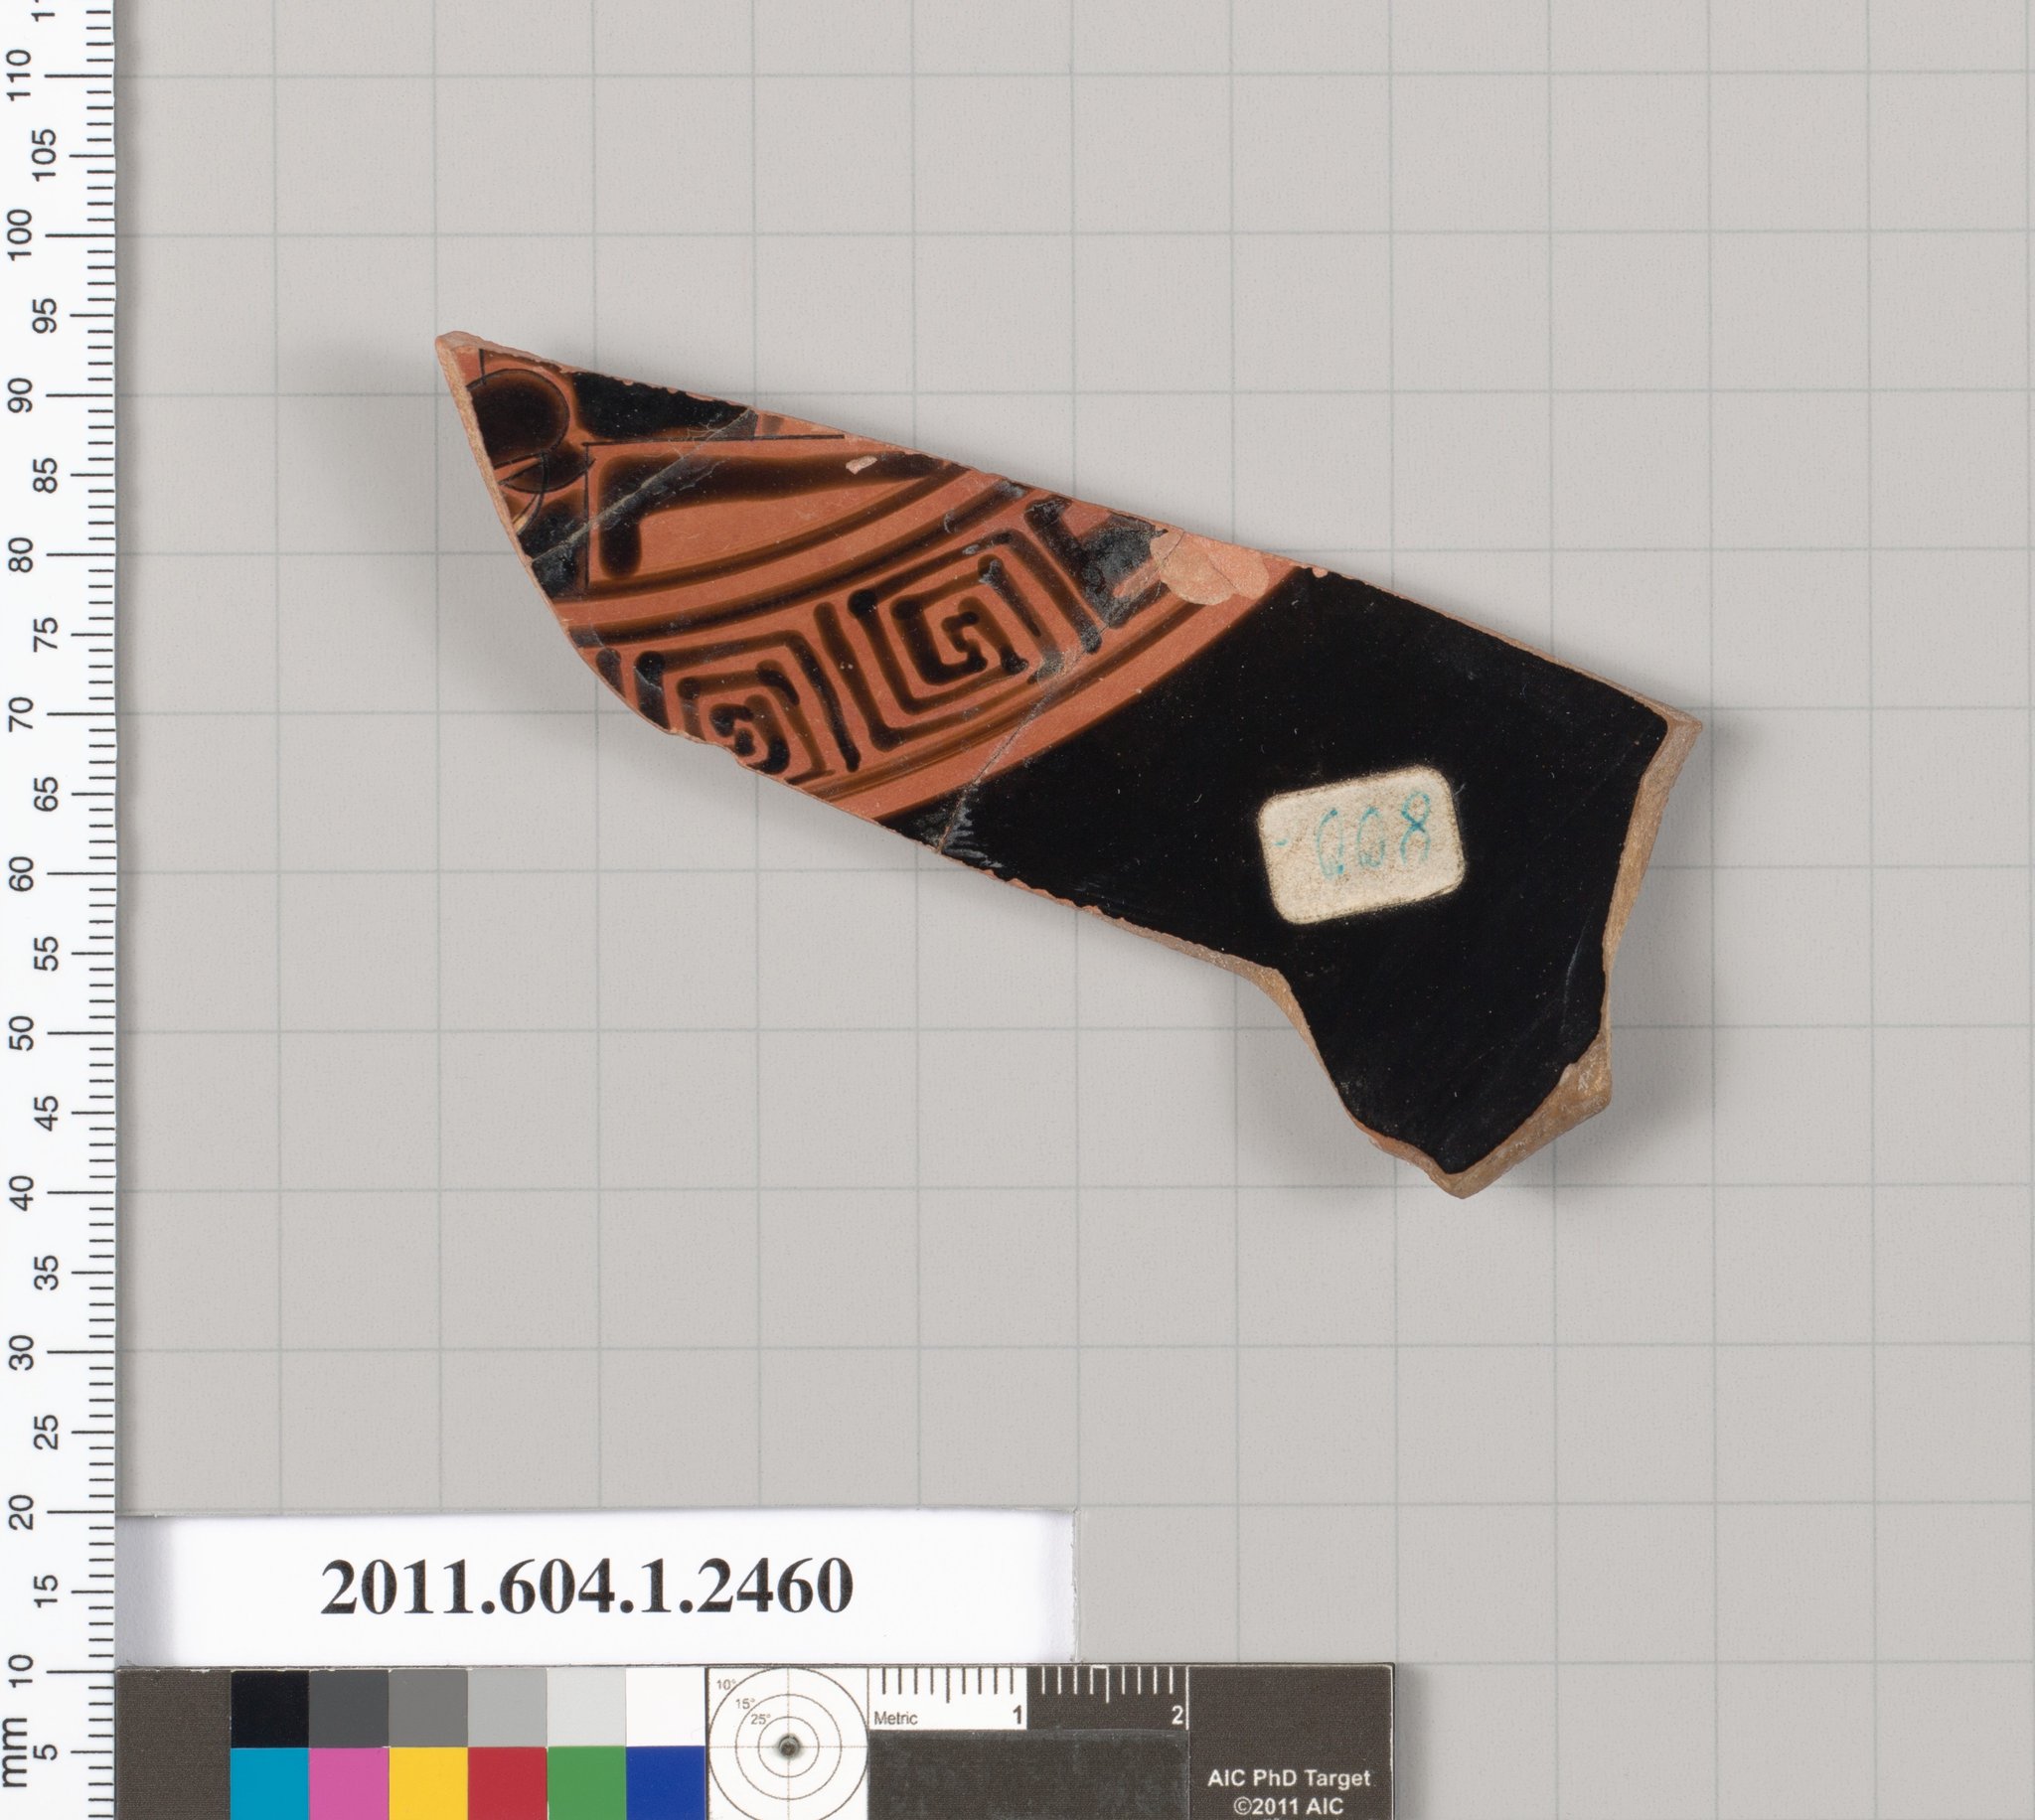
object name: kylix fragment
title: Terracotta fragment of a kylix (drinking cup)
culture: greek, attic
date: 500-451 BCE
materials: terracotta